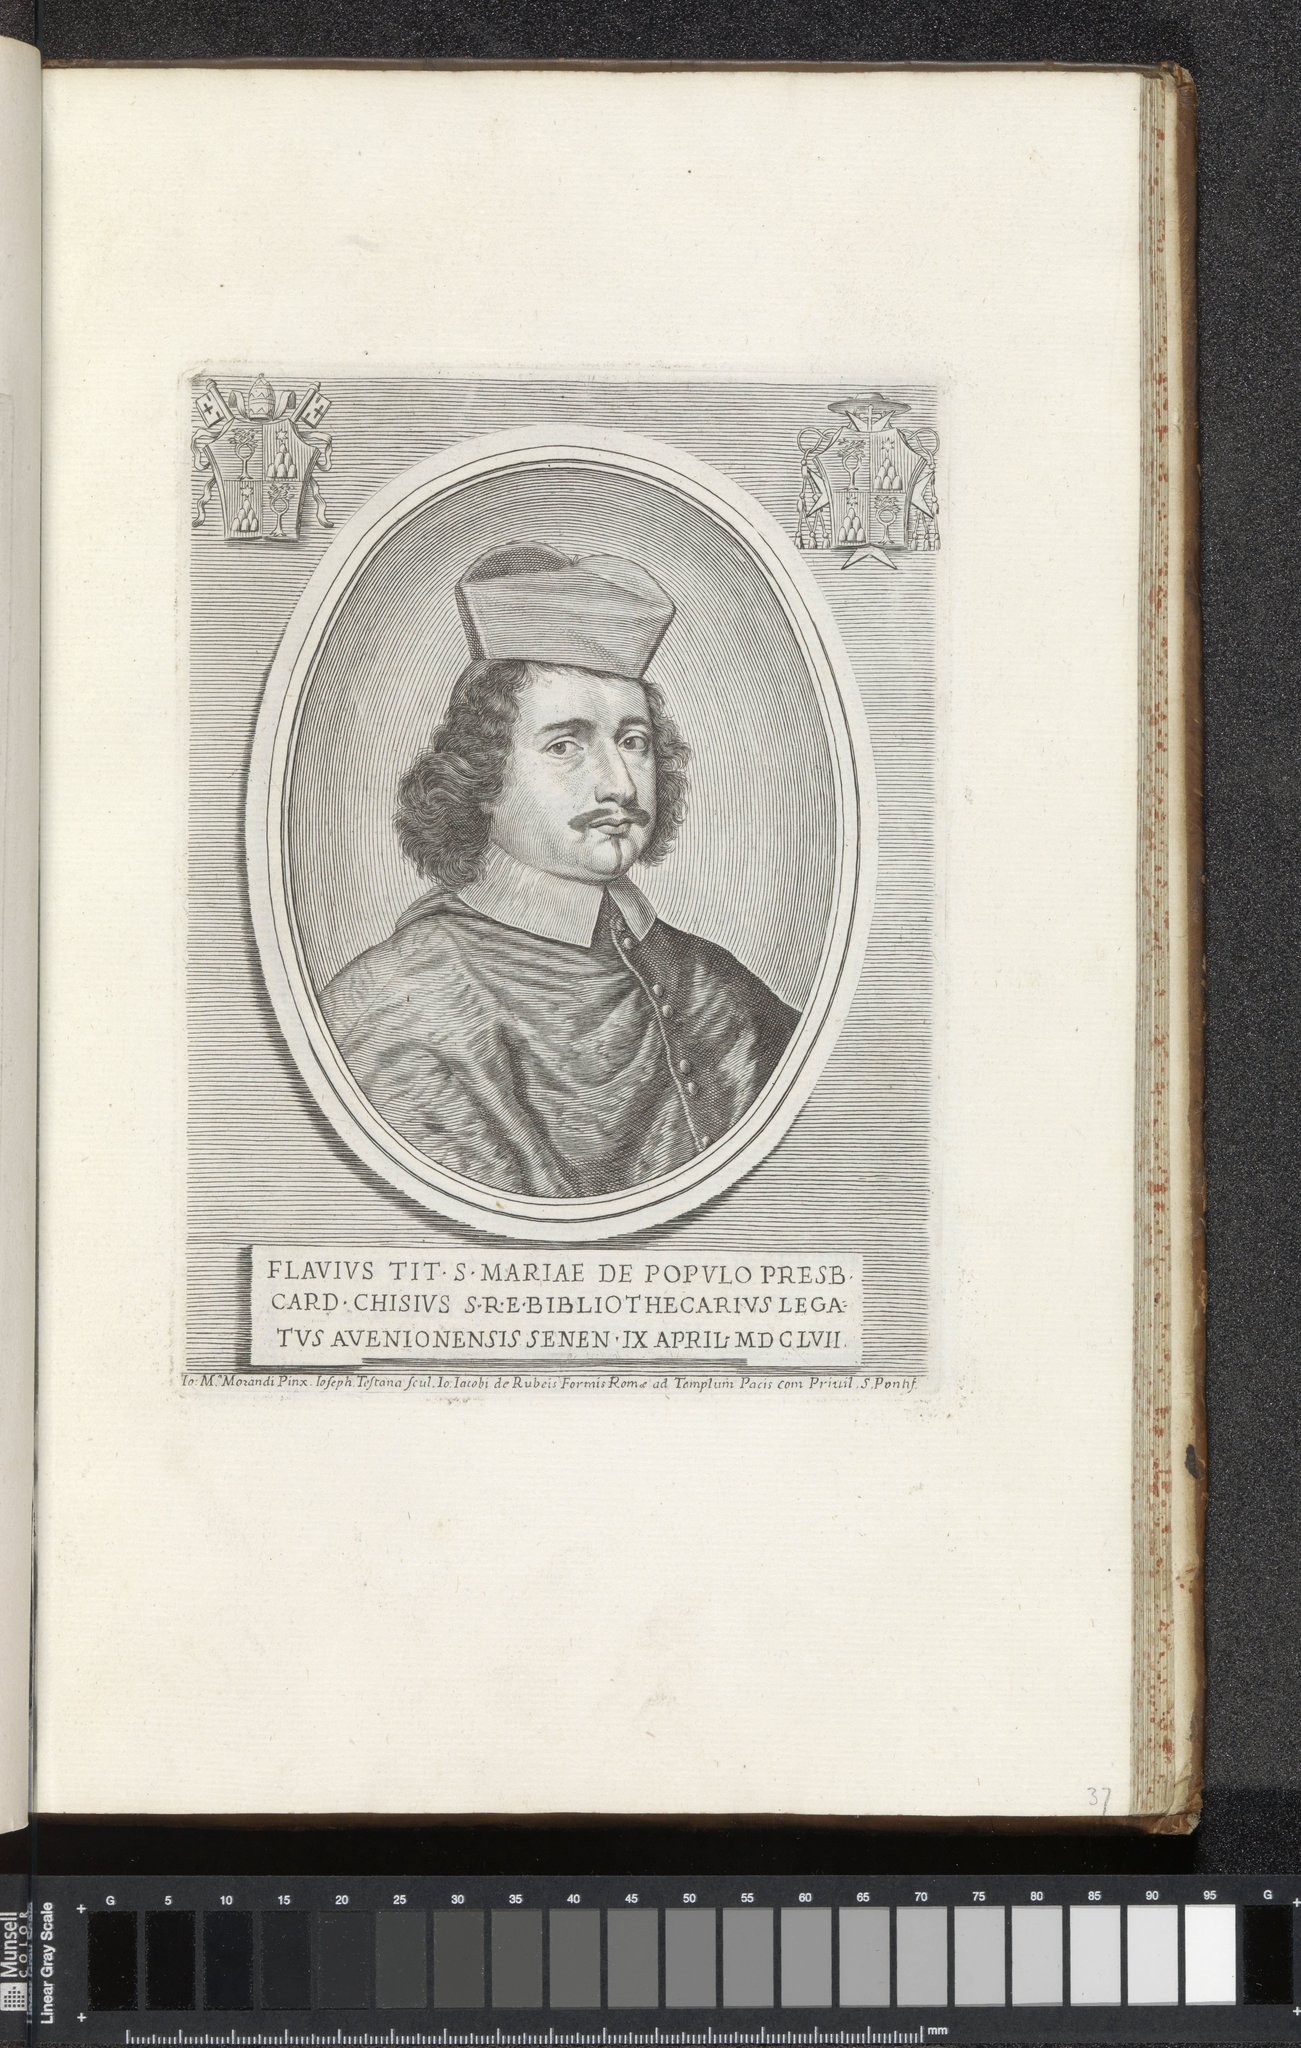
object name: album leaf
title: Portret van kardinaal Flavio Chigi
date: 1658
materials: paper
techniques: engraving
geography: rome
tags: flavio chigi, cardinal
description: Portret van kardinaal Flavio Chigi. Linksboven het wapen van paus Alexander VII en rechtsboven het wapen van de kardinaal. Onderaan een onderschrift in het Latijn. De prent maakt deel uit van een album.